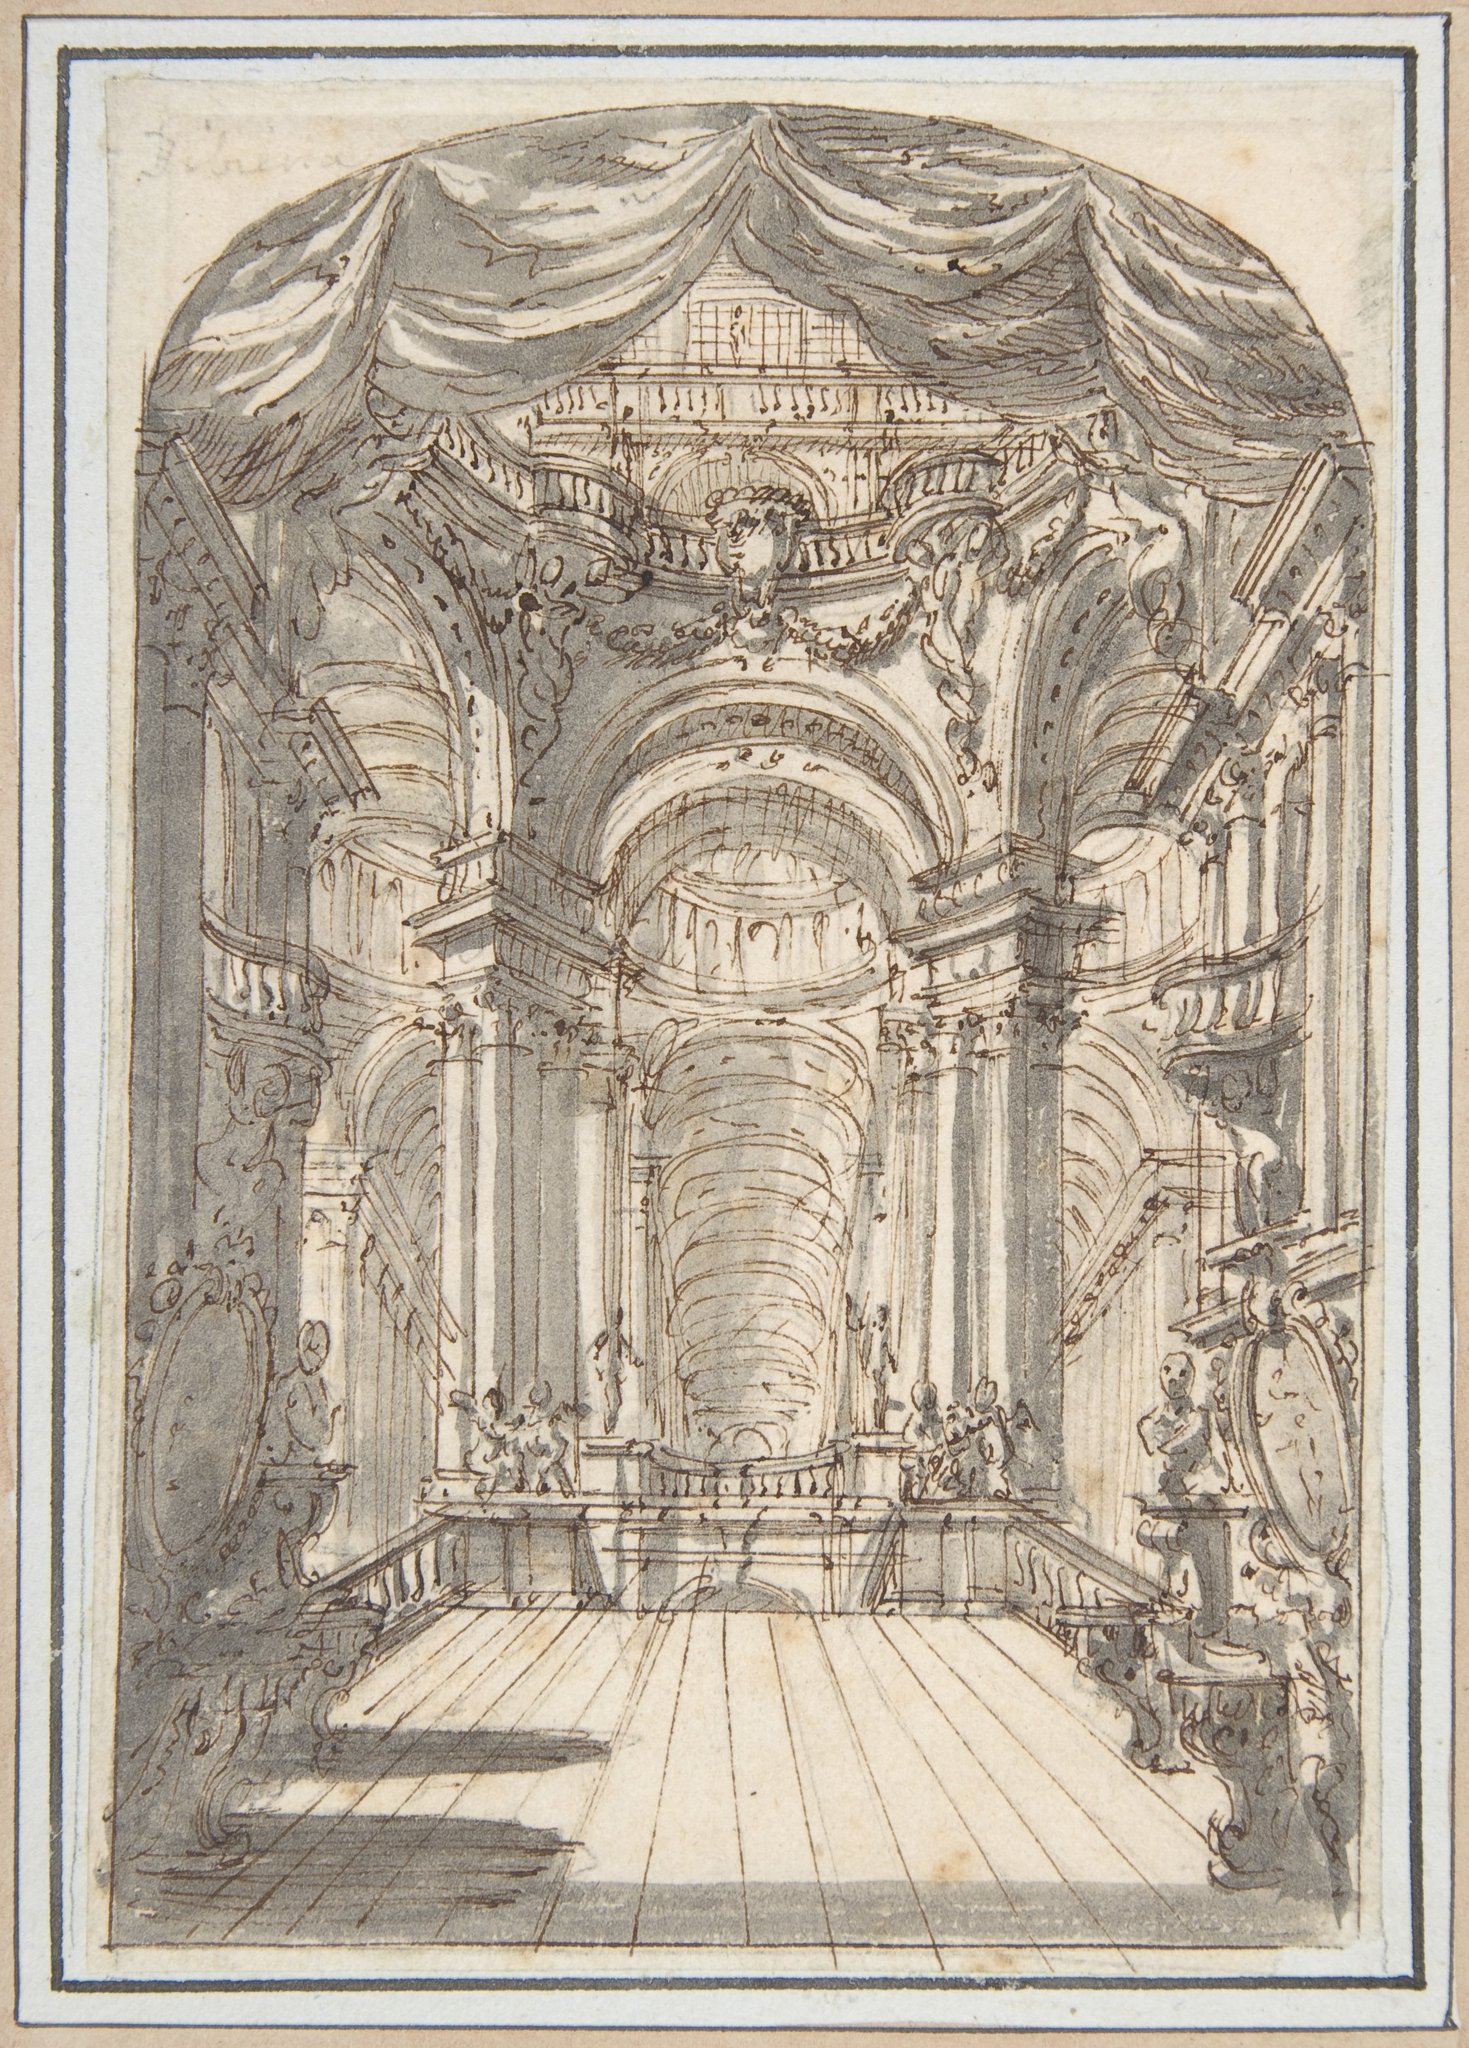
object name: ornament architecture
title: Perspectival Sketch for a Palace Interior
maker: giuseppe galli bibiena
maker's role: artist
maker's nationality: italian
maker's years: 1696-1756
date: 1696-1756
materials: graphite, ink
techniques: brush, pen, wash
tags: palaces,interiors